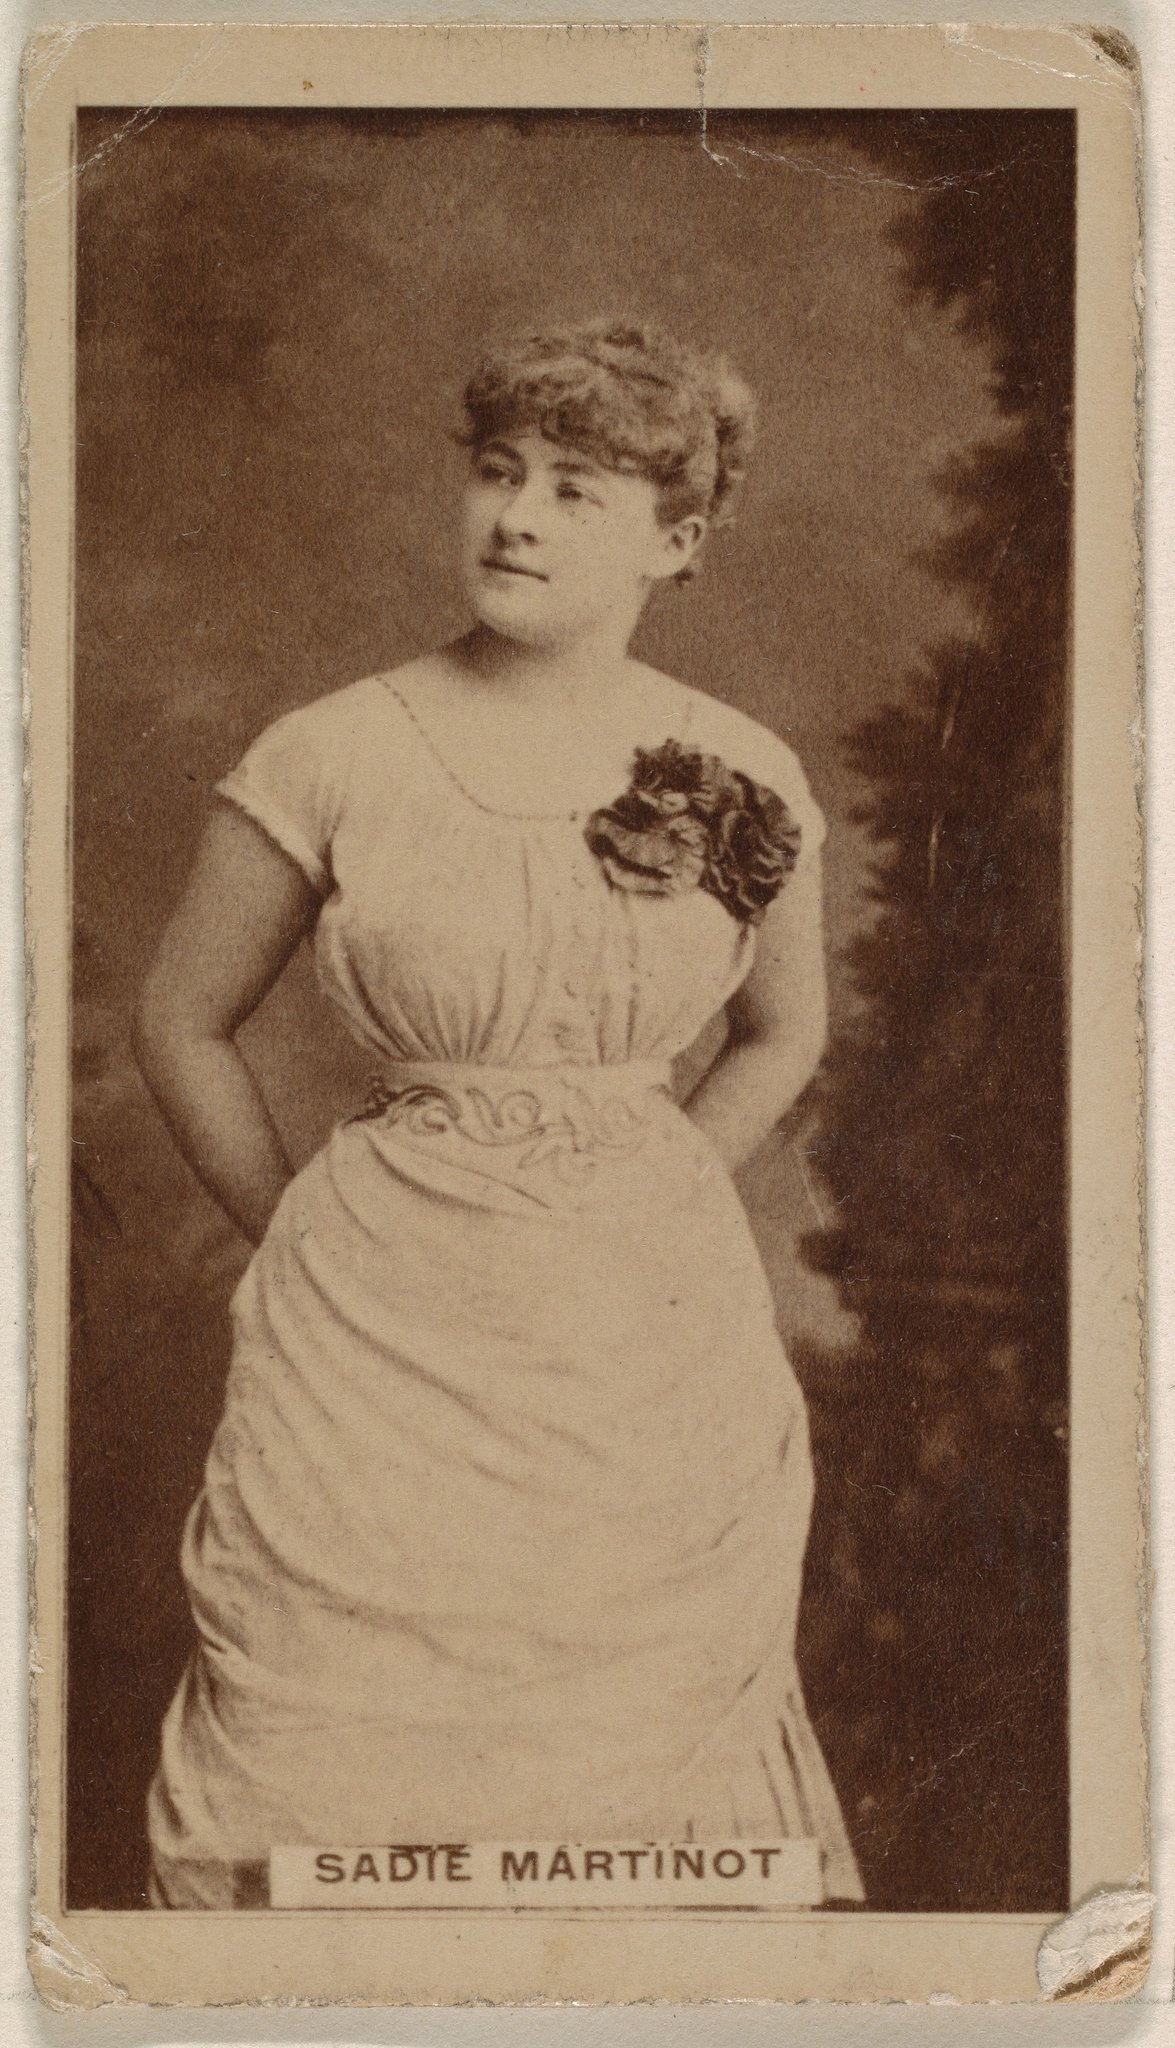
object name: photograph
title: Sadie Martinot, from the Actresses series (N245) issued by Kinney Brothers to promote Sweet Caporal Cigarettes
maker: kinney brothers tobacco company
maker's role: publisher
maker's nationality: american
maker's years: 1869-2011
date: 1890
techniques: albumen silver print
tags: portraits,women,actresses